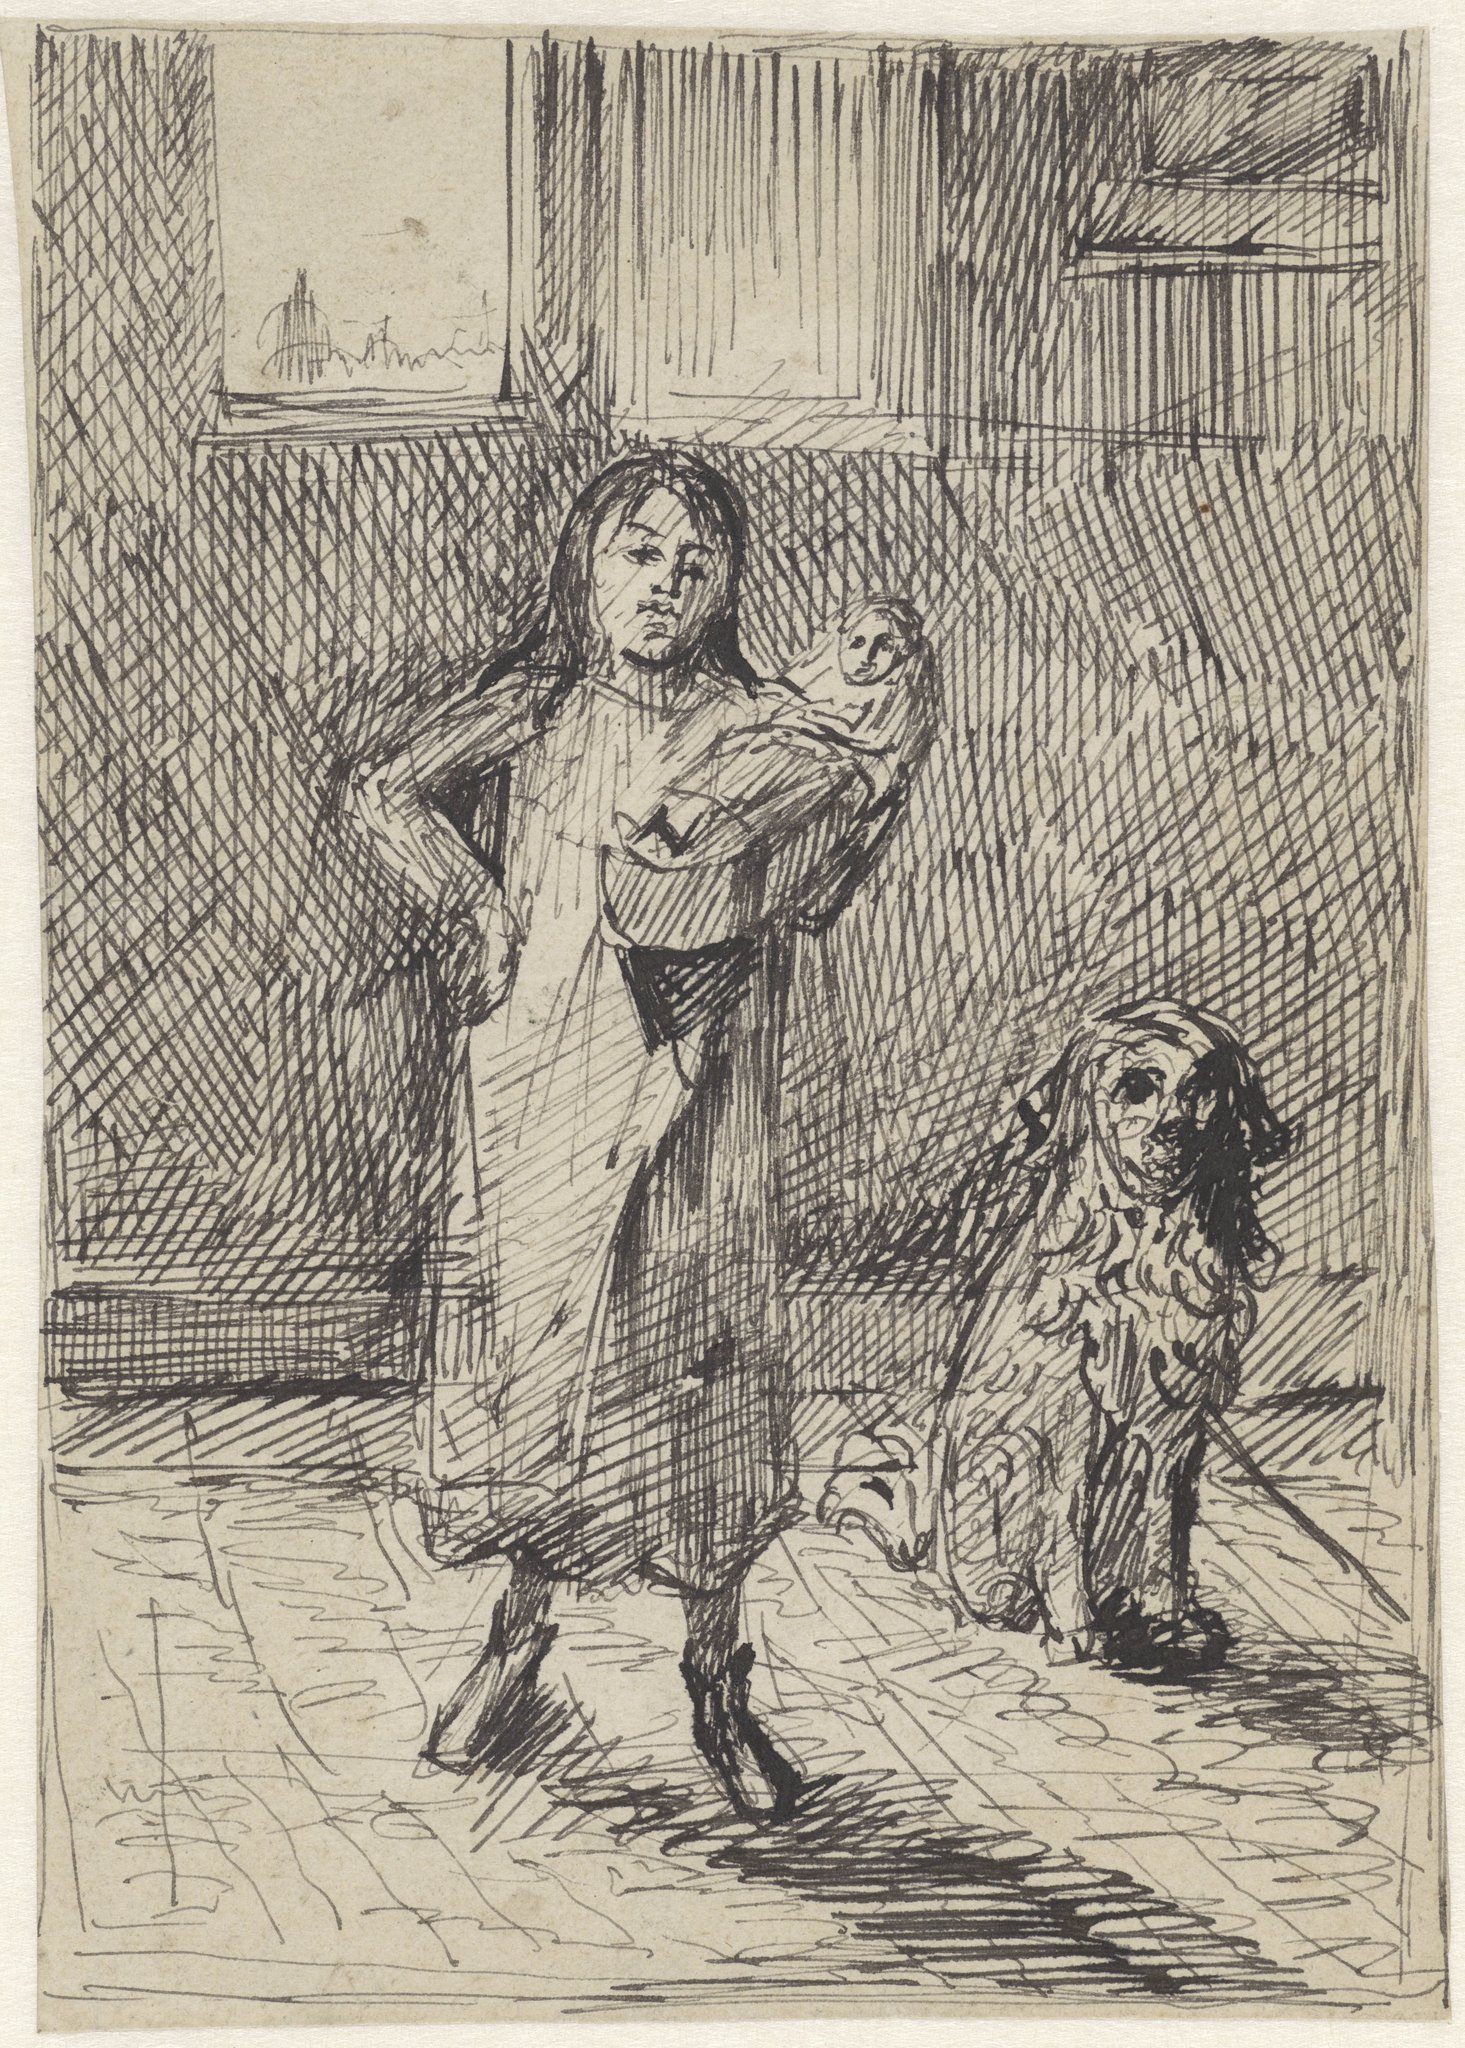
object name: drawing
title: Meisje met pop en hond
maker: thomas cool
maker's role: draughtsman, painter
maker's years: 1851-1904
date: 1861-1904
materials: ink, paper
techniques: pen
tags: girl (child between toddler and youth), (playing with) dolls, dog